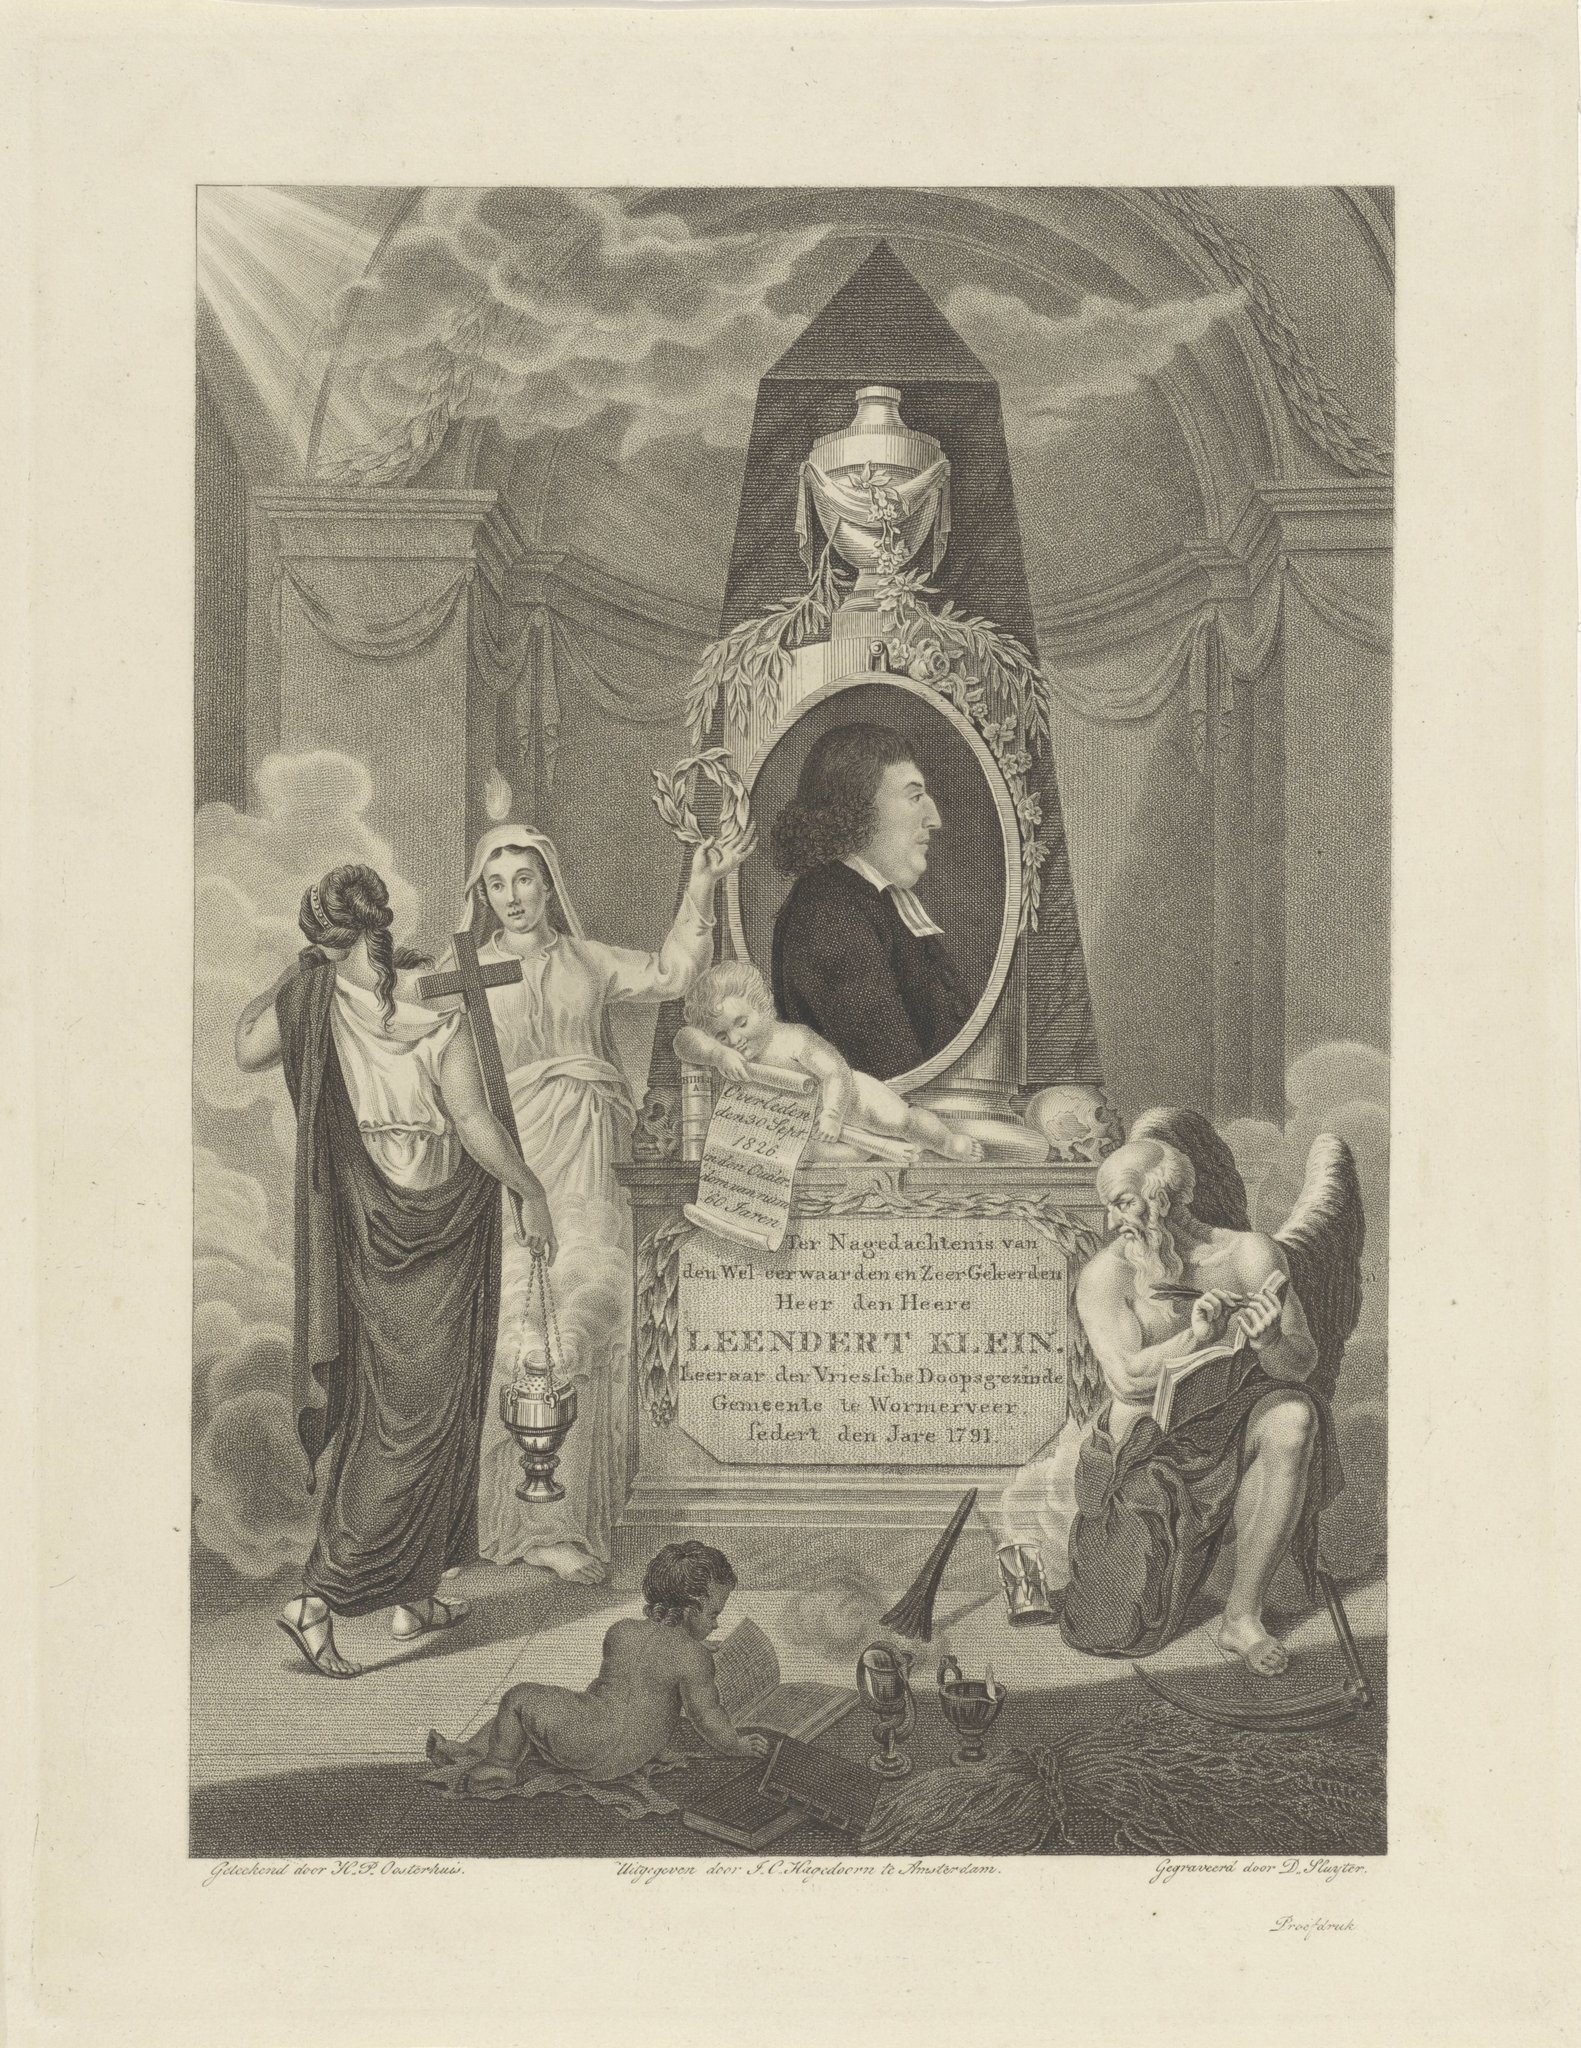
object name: print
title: Monument voor Leendert Klein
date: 1826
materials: paper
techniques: engraving, etching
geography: amsterdam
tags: fugacity of time, grave-building, monumental tomb, father time, man with wings and scythe, allegories and personifications ~ protestantism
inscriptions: collector's mark: Lugt 2228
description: Grafmonument met daarop het portret van Leendert Klein, predikant in de Doopsgezinde gemeente te Wormerveer. Het portret wordt geflankeerd door een schedel en een bijbel, waarop een slapende putto steunt. Deze houdt een een gedoofde fakkel vast en een papier met daarop de overlijdensdatum. Eronder een opschrift met zijn functie, en de jaren waarin hij in zijn gemeente werkzaam was. Naast het monument staan Geloof, met kruis en wierookvat, en Godsdienst. Vadertje Tijd zit geknield naast het monument, schrijvend in een boek. Op de voorgrond zit een putto met boeken, een door een slang omslingerde beker, een brandende lamp en een korenschoof.